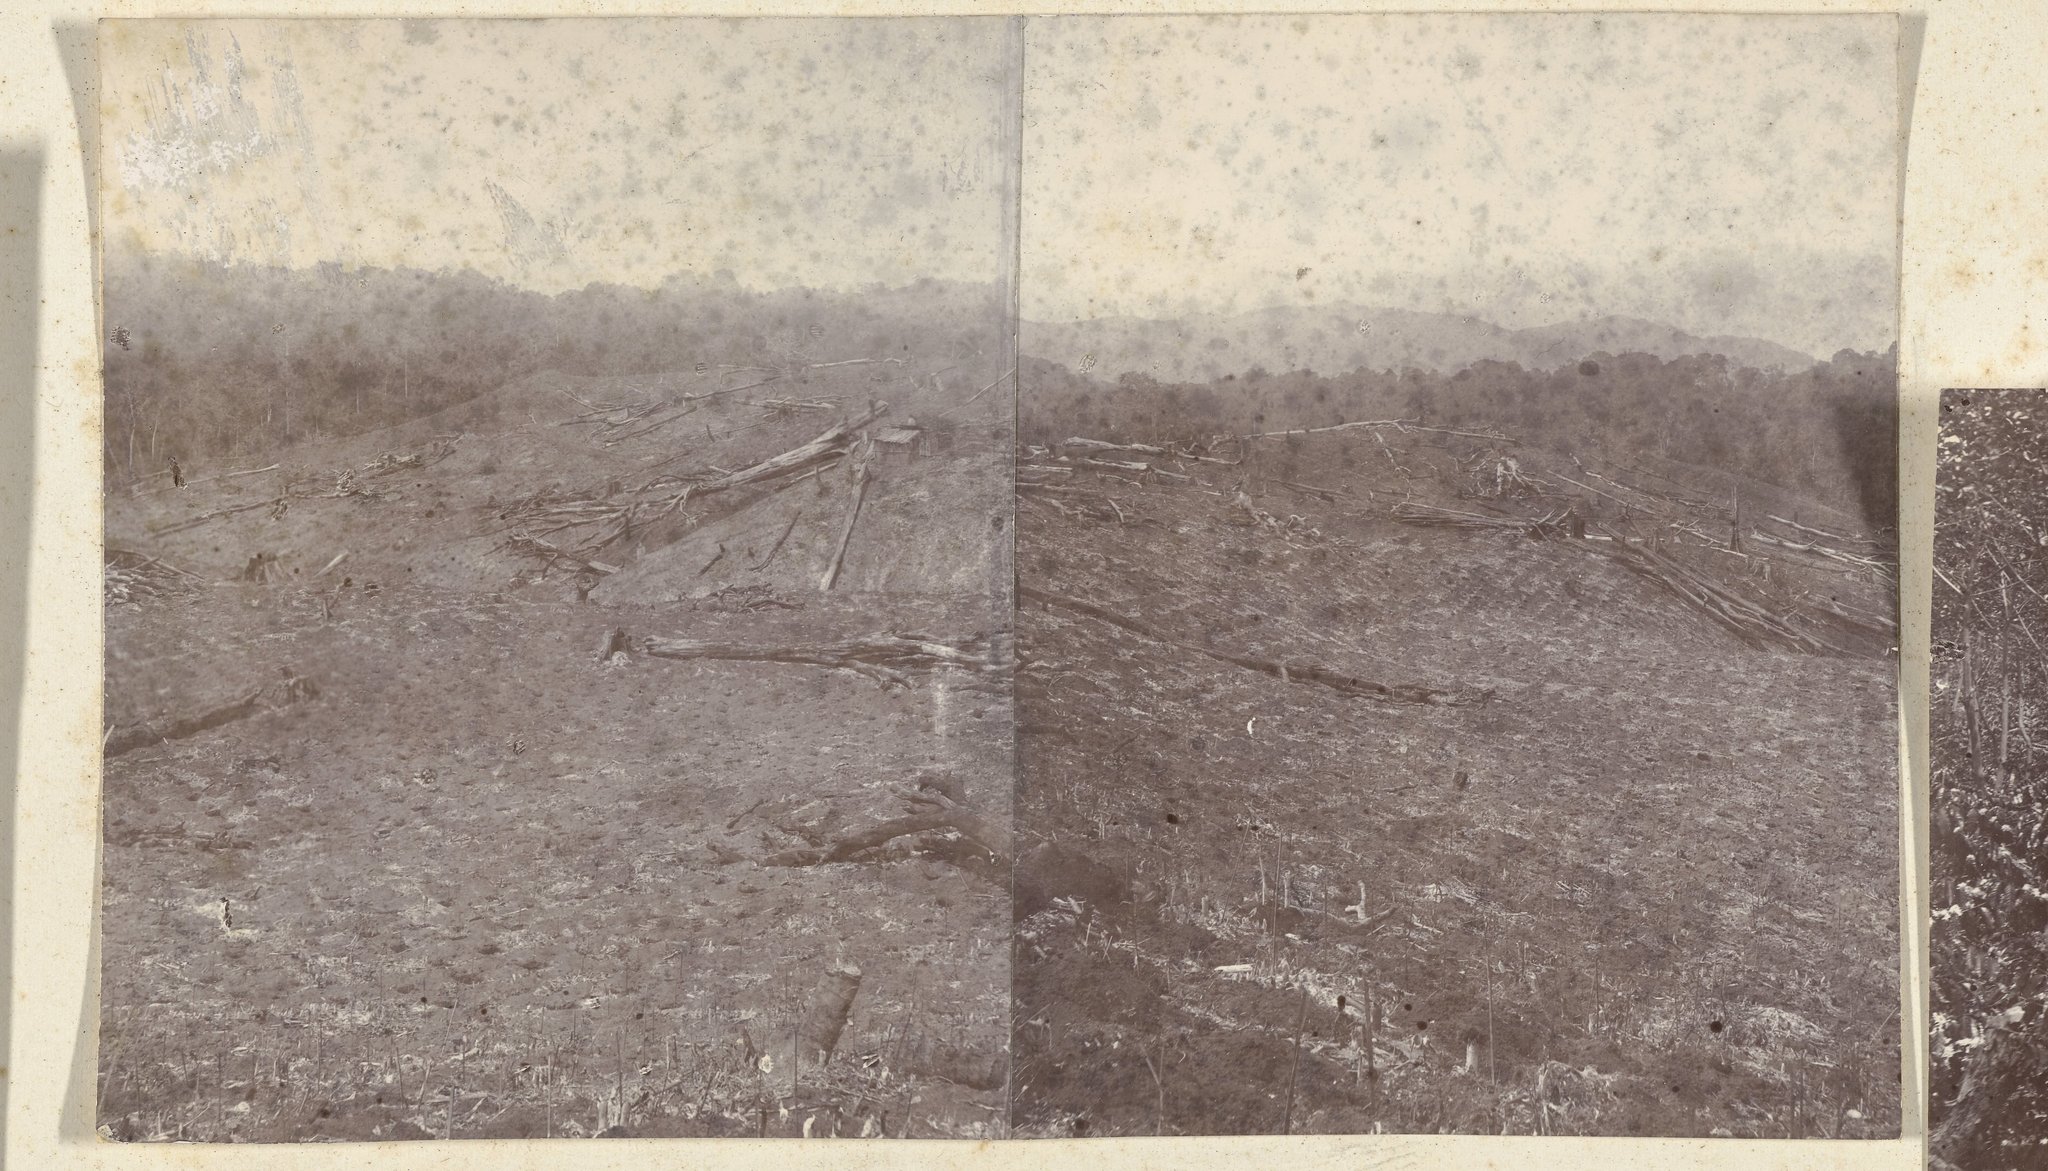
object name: panoramic photograph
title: Gezicht op de gekapte vlaktes voor de aanleg van koffievelden van plantage Silo Sanen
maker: Anonymous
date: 1890-1910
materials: cardboard, photographic support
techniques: gelatin silver print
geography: indonesia